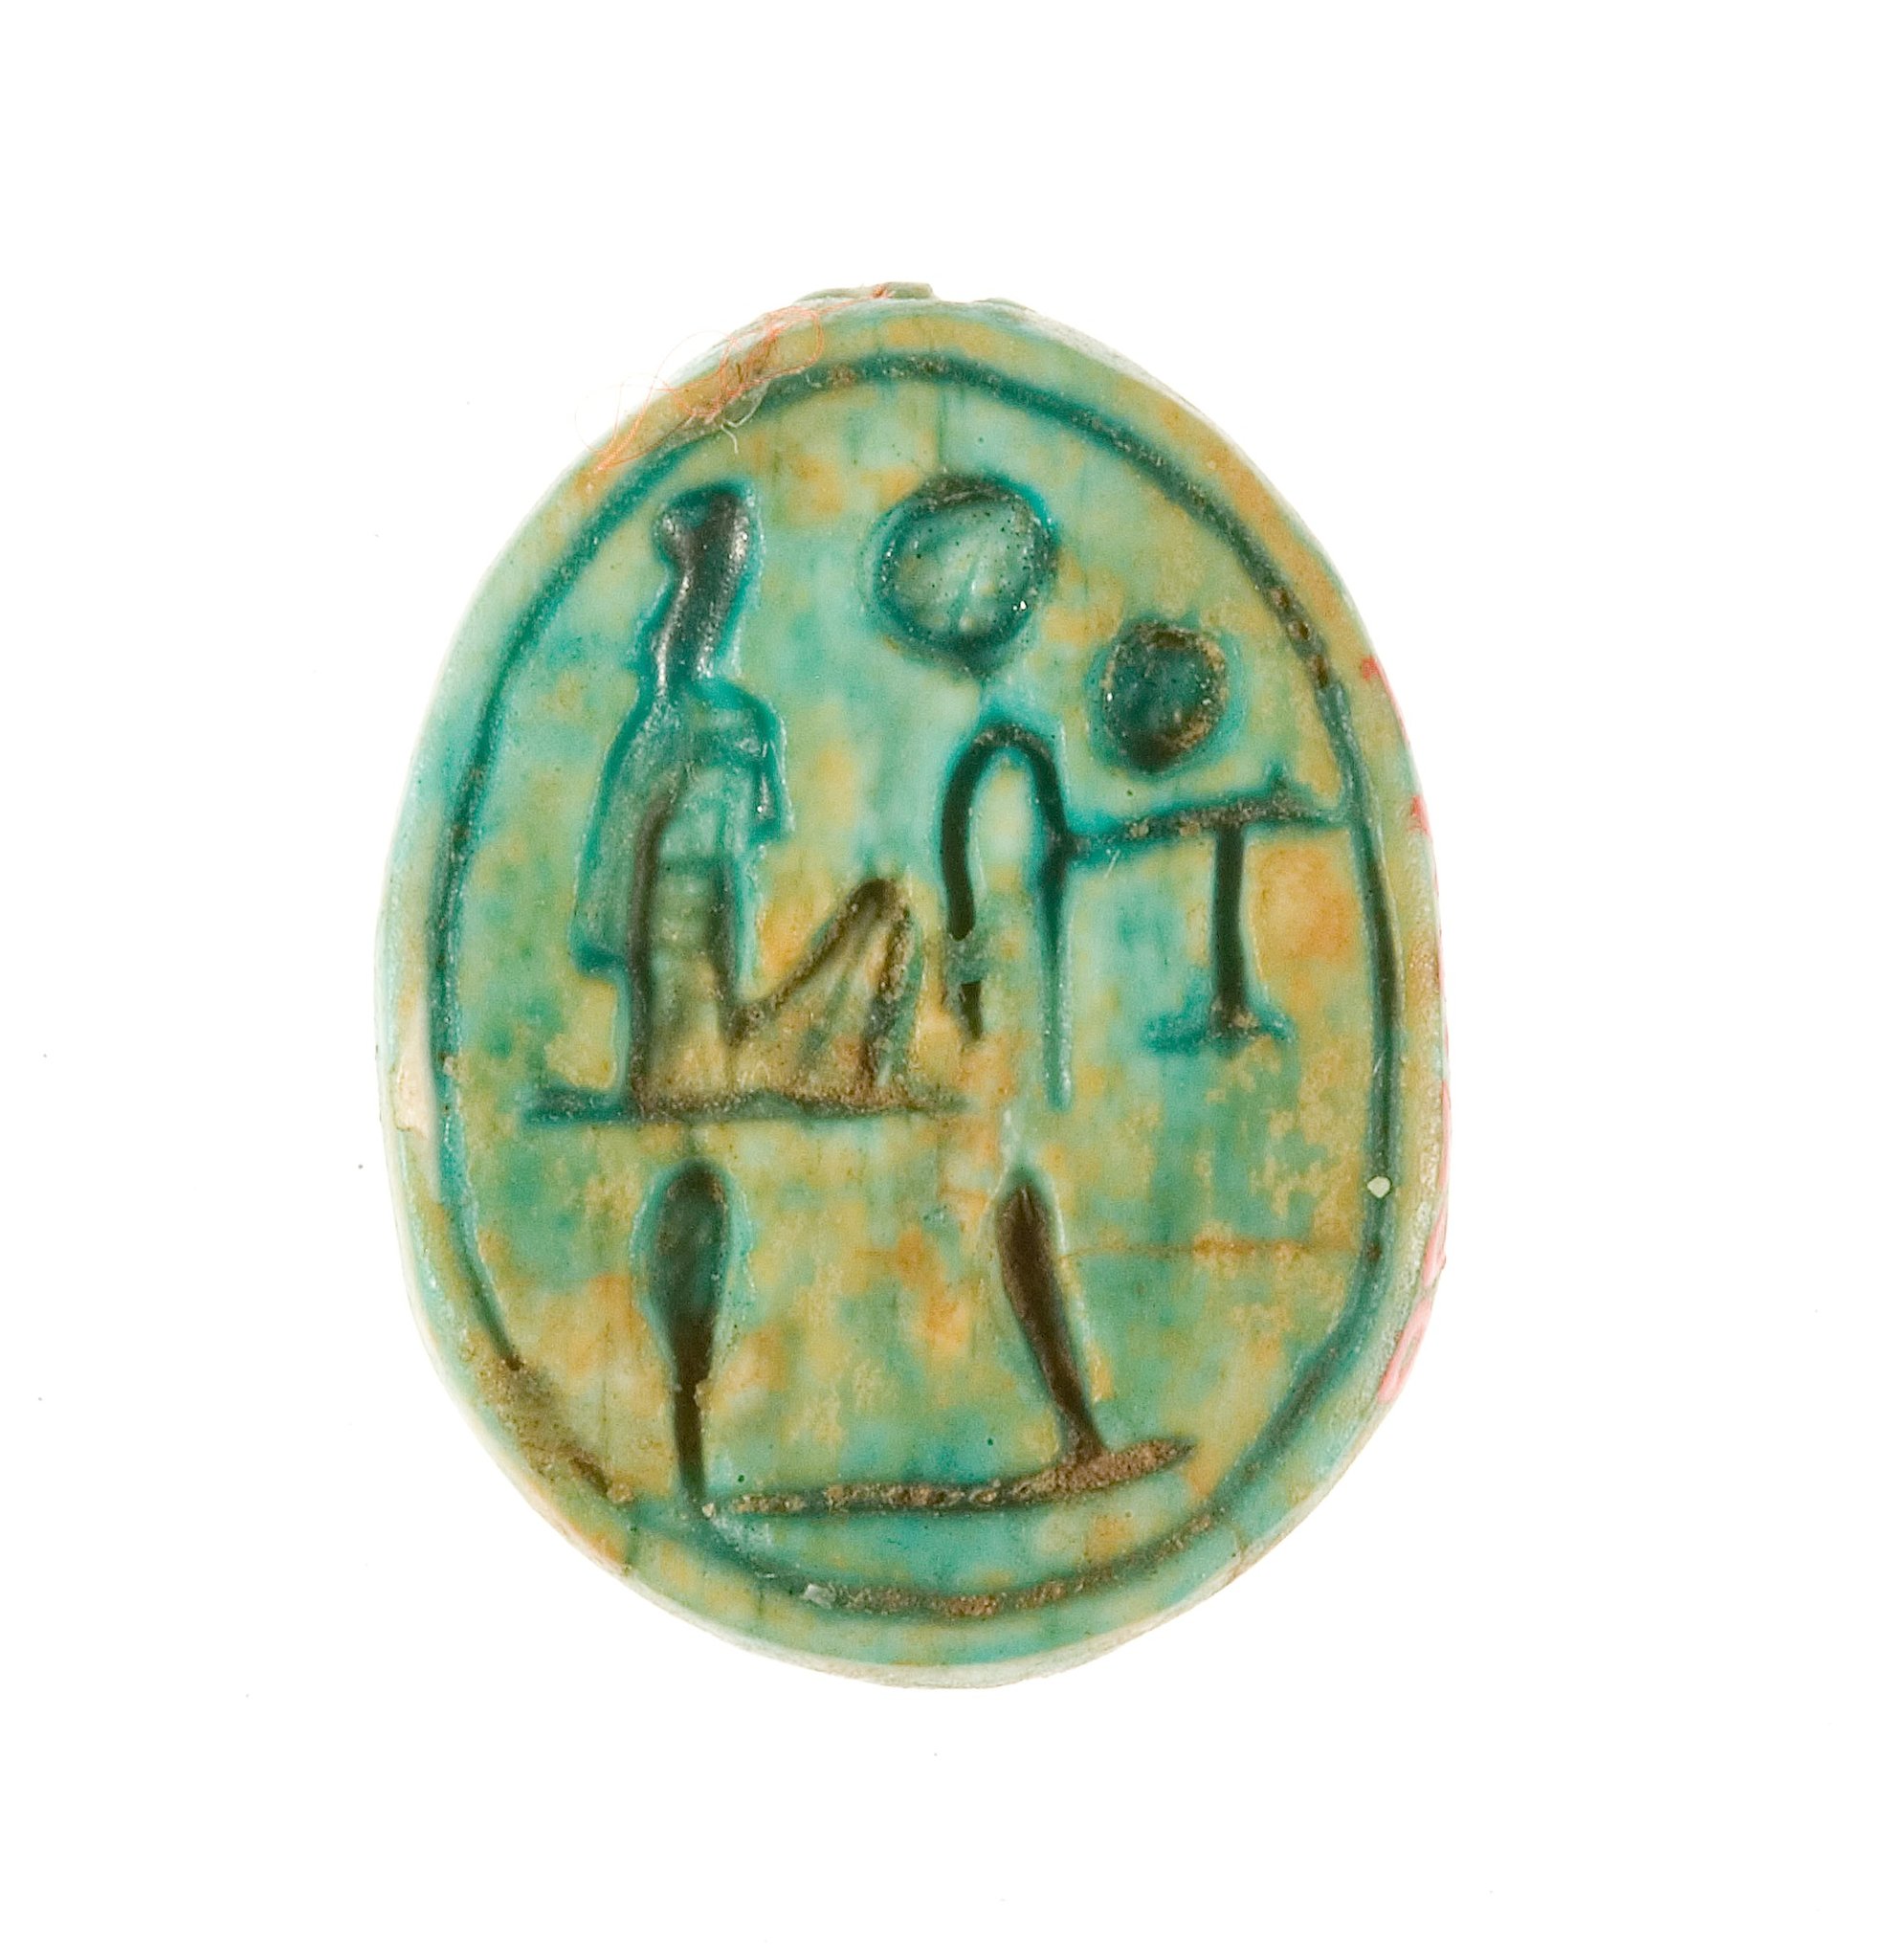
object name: scarab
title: Scarab Inscribed Maatkare (Hatshepsut), She Lives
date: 1479-1458 BCE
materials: stone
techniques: glazing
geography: egypt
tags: scarabs